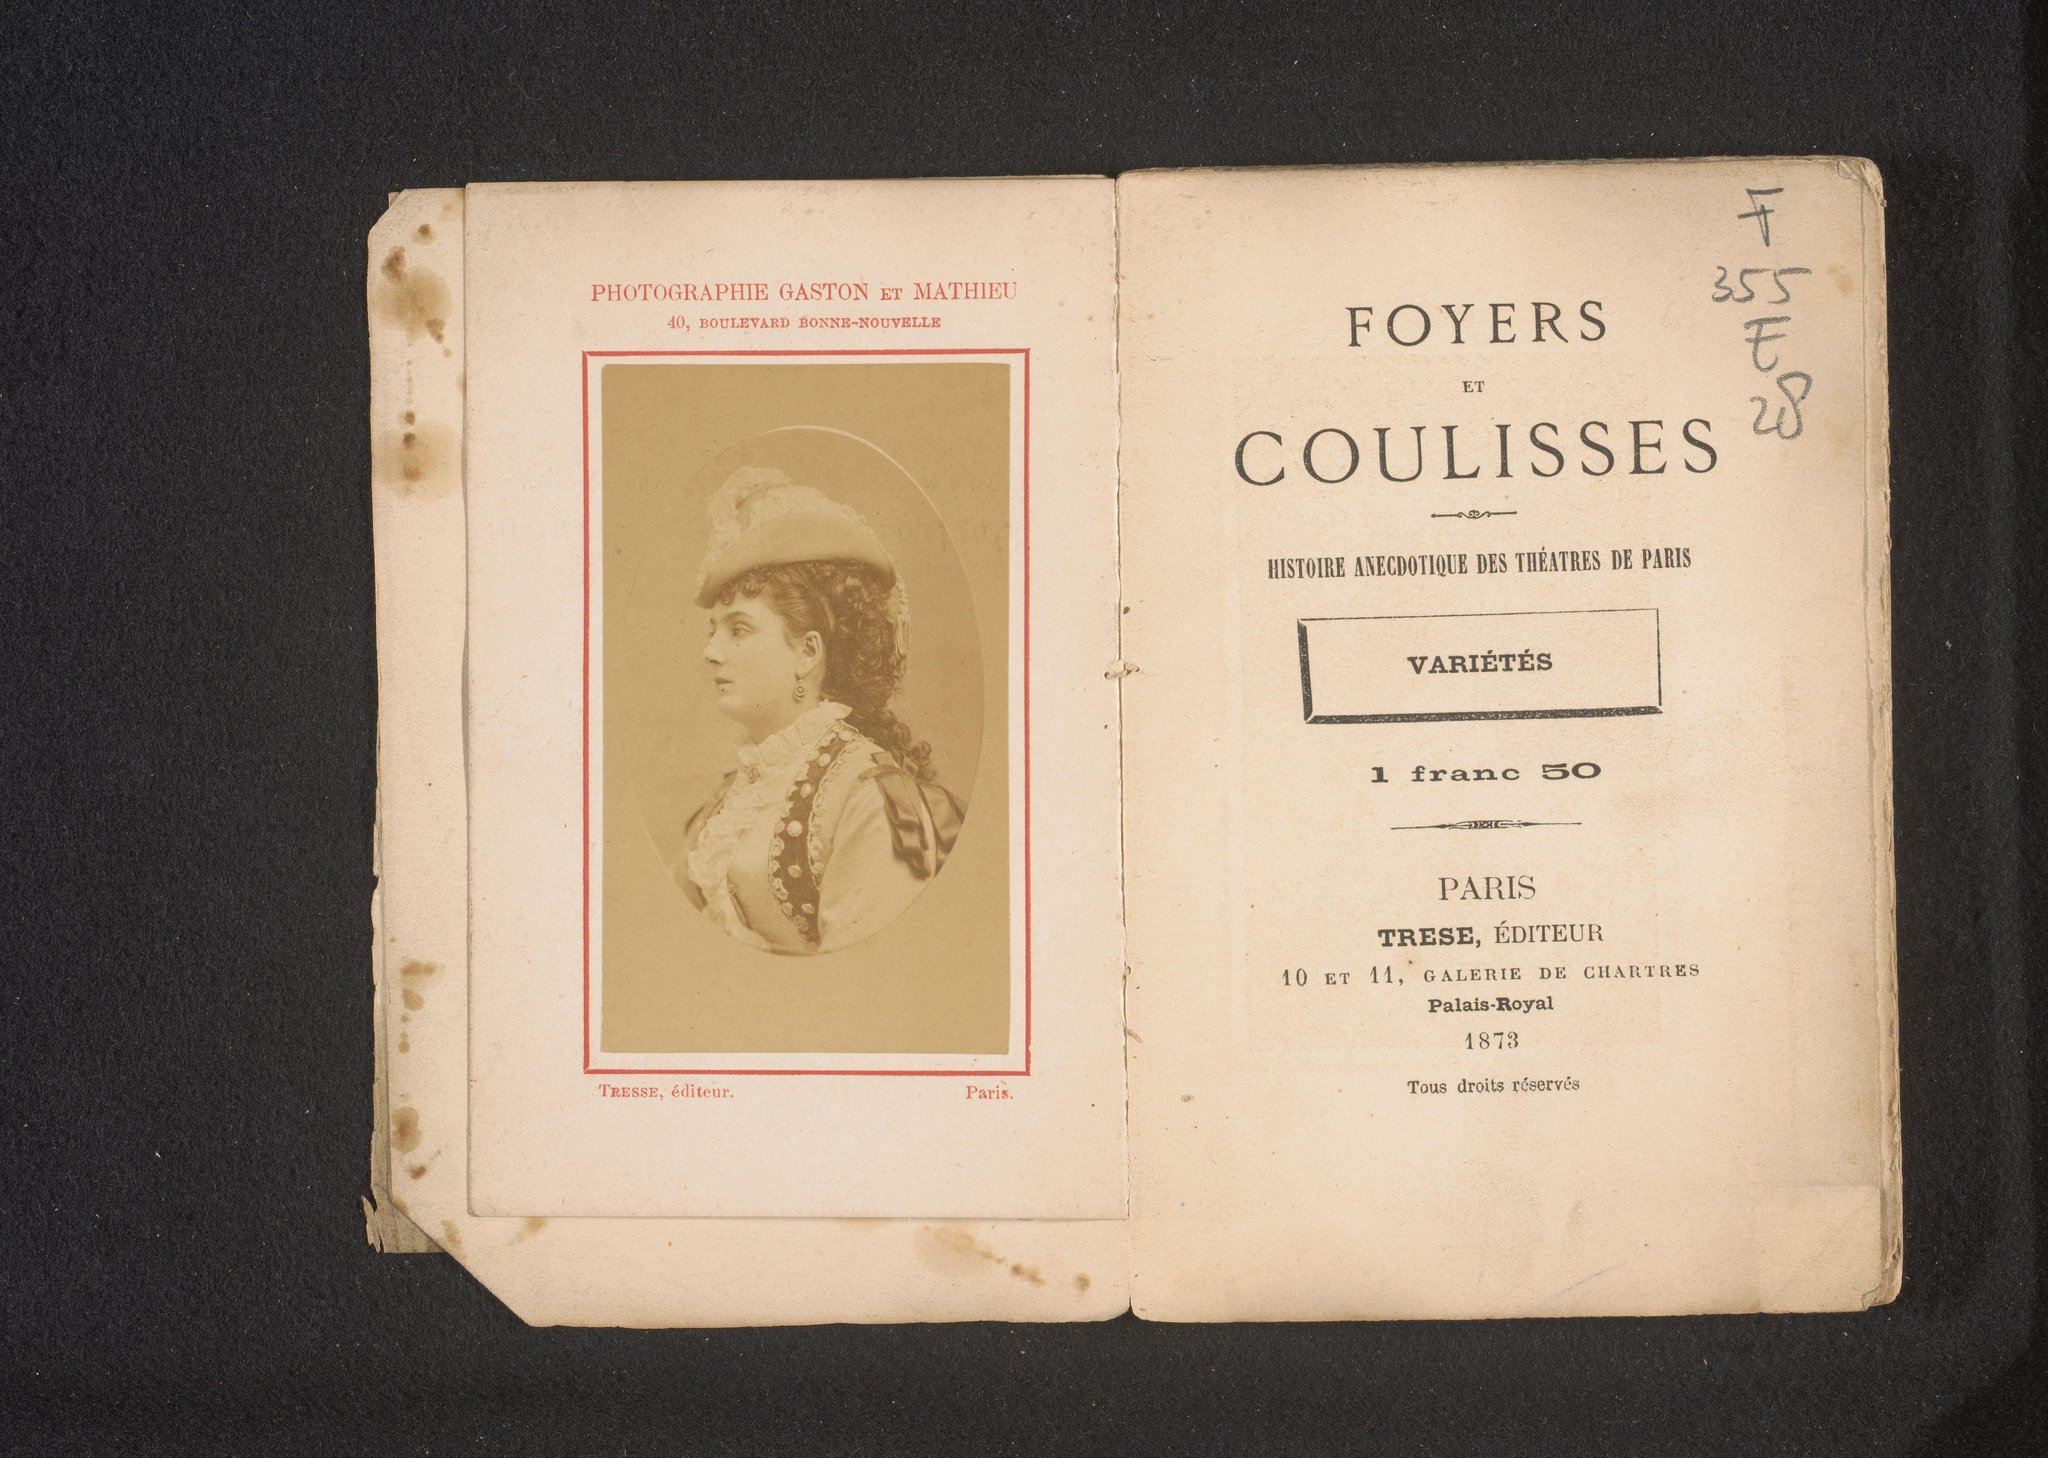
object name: page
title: Portret van een Franse actrice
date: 1863-1873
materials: photographic support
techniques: albumen print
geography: paris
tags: portrait of actor, actress